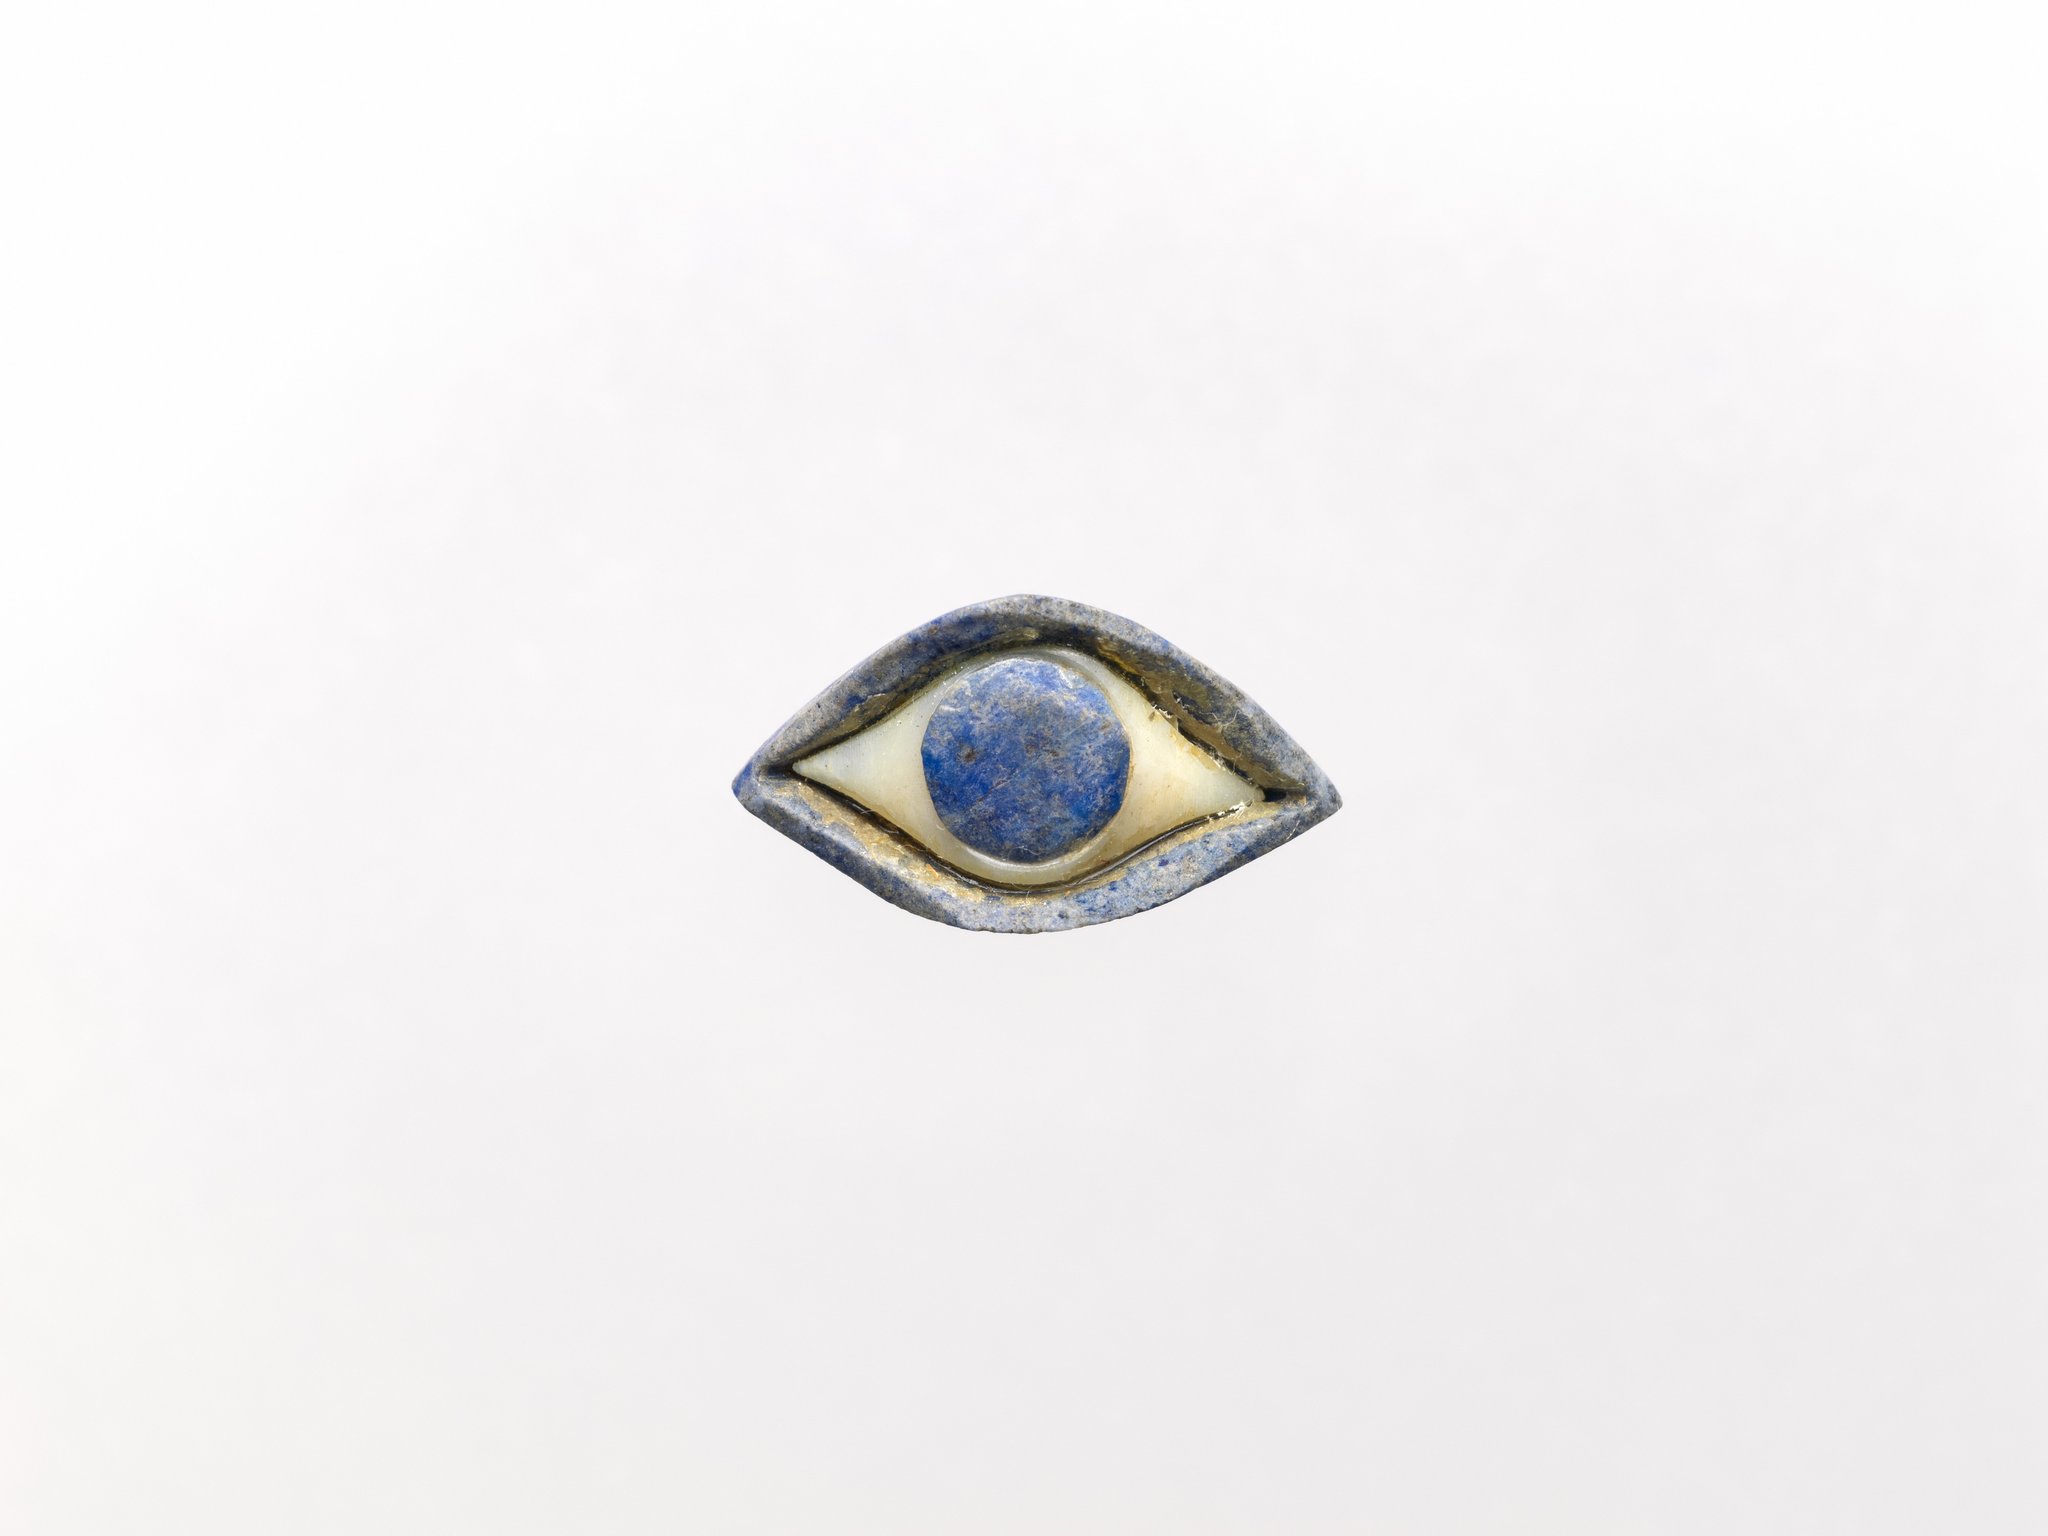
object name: eye inlay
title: Eye inlay for a statue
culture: sumerian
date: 2600-2500 BCE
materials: lapis lazuli, shell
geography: mesopotamia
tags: eyes